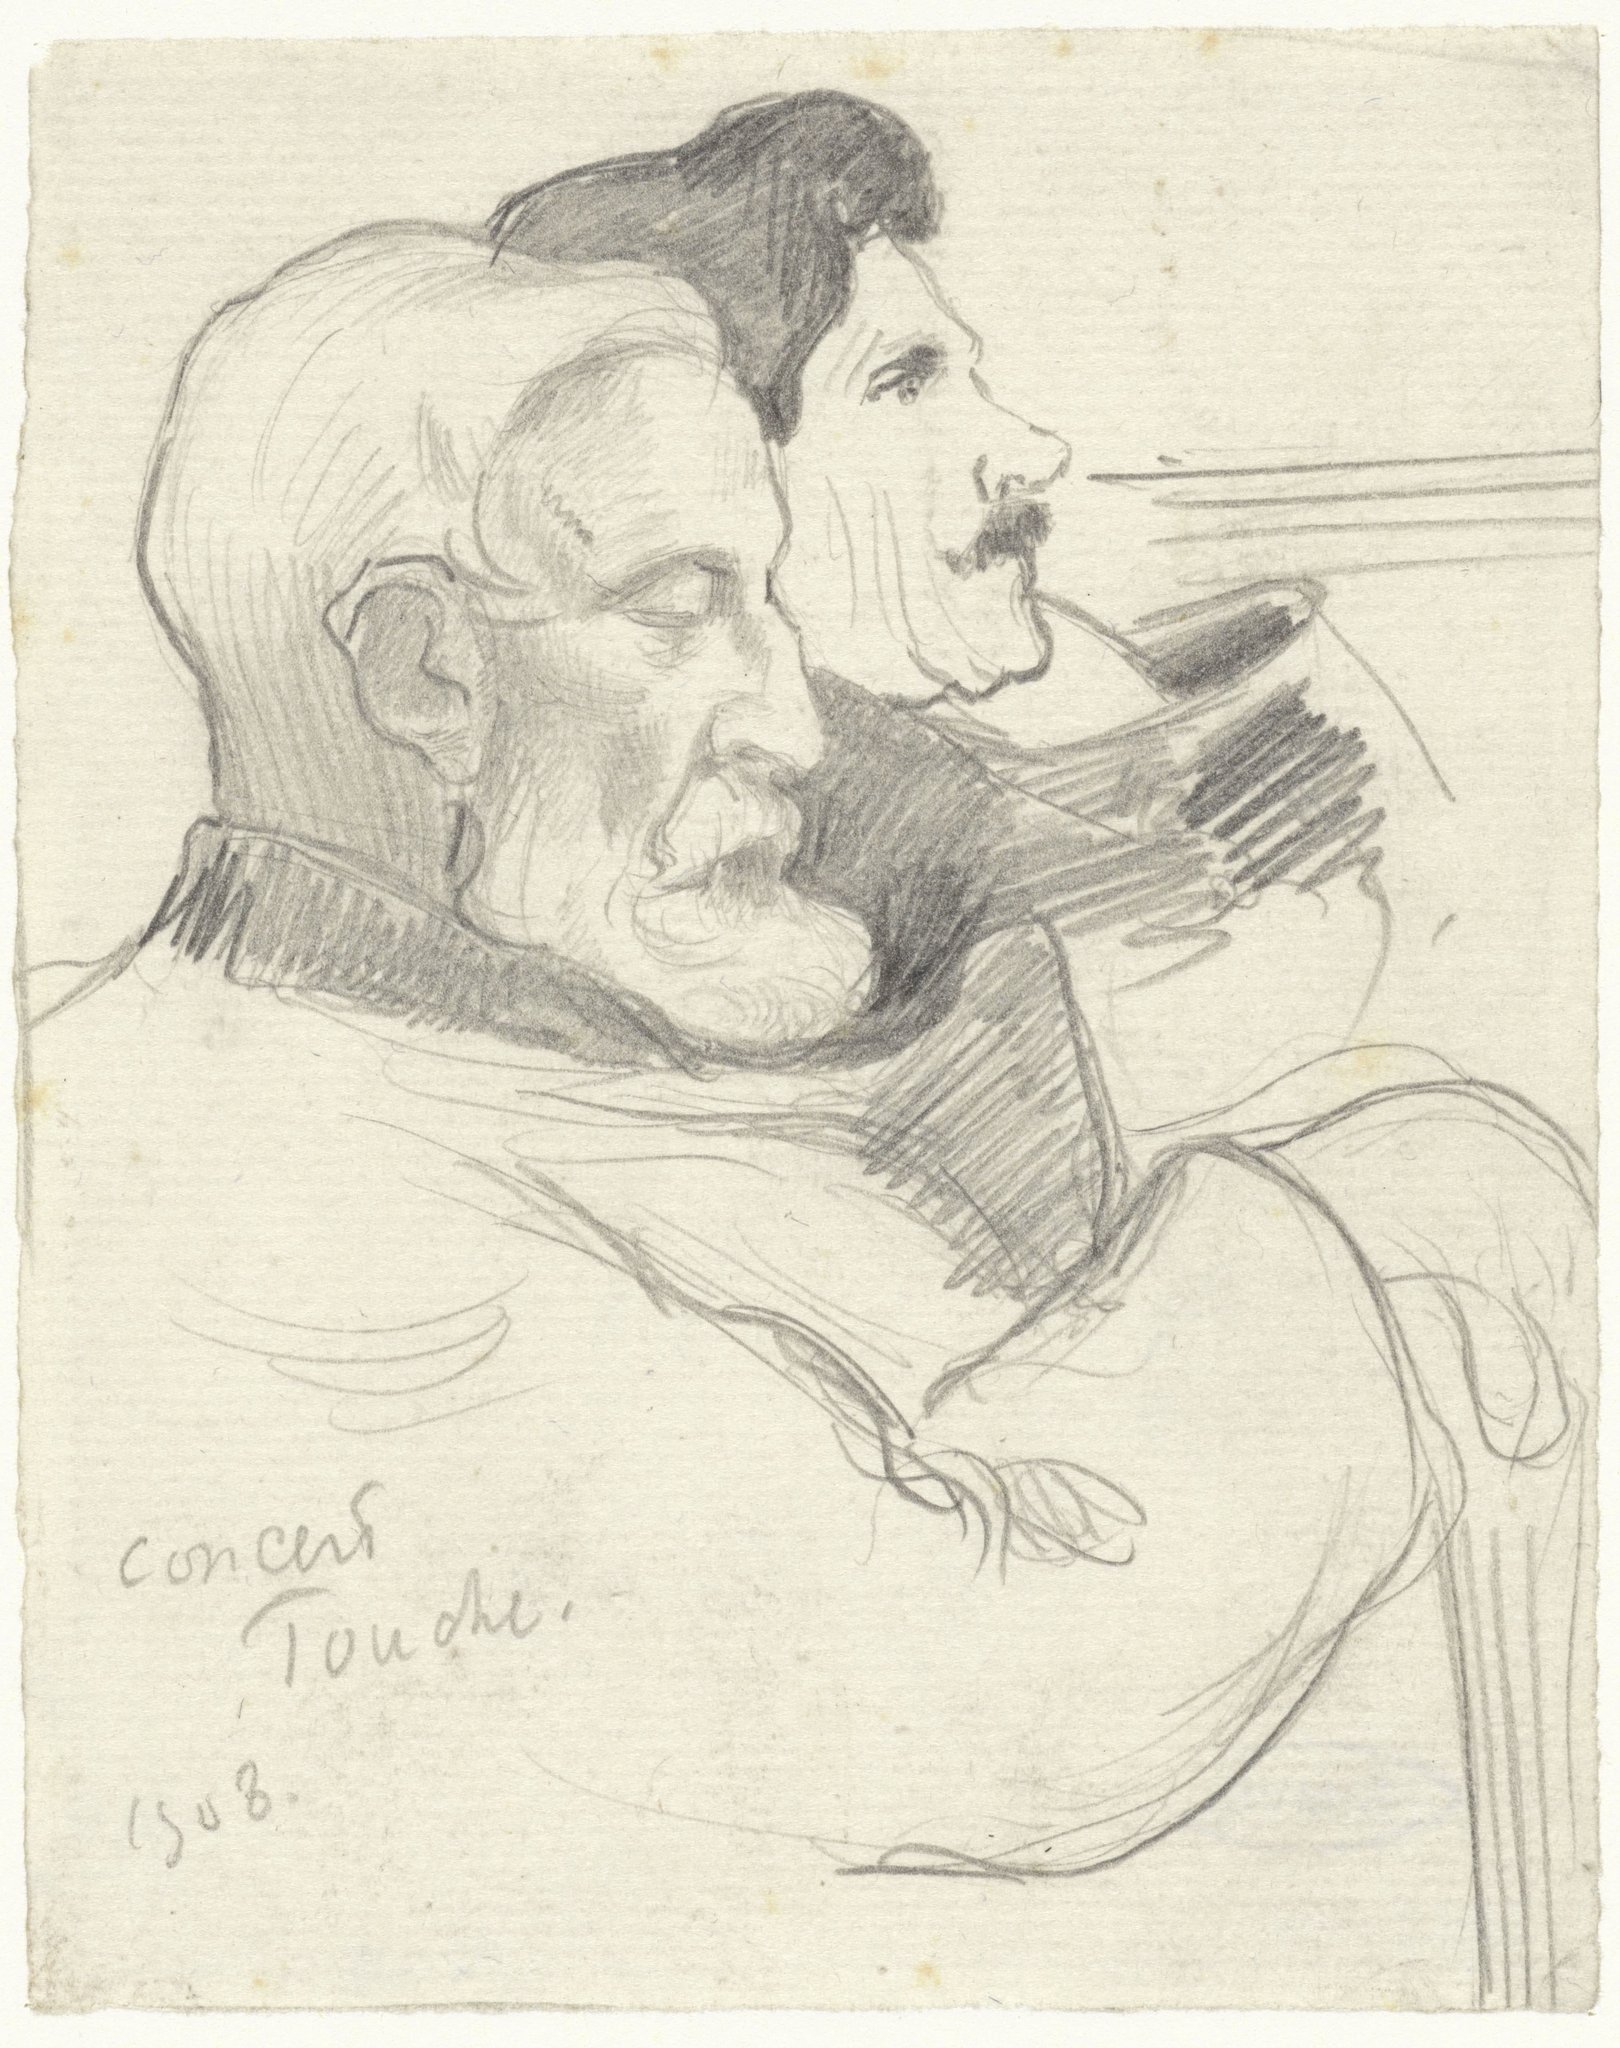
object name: drawing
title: Twee concertbezoekers in de muziekzaal Touche, te Parijs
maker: richard nicolaüs roland holst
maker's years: 1868-1938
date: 1908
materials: paper, pencil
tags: music-hall, listening to music, names of organizations, companies, trade unions, etc., the audience ~ art performance, paris